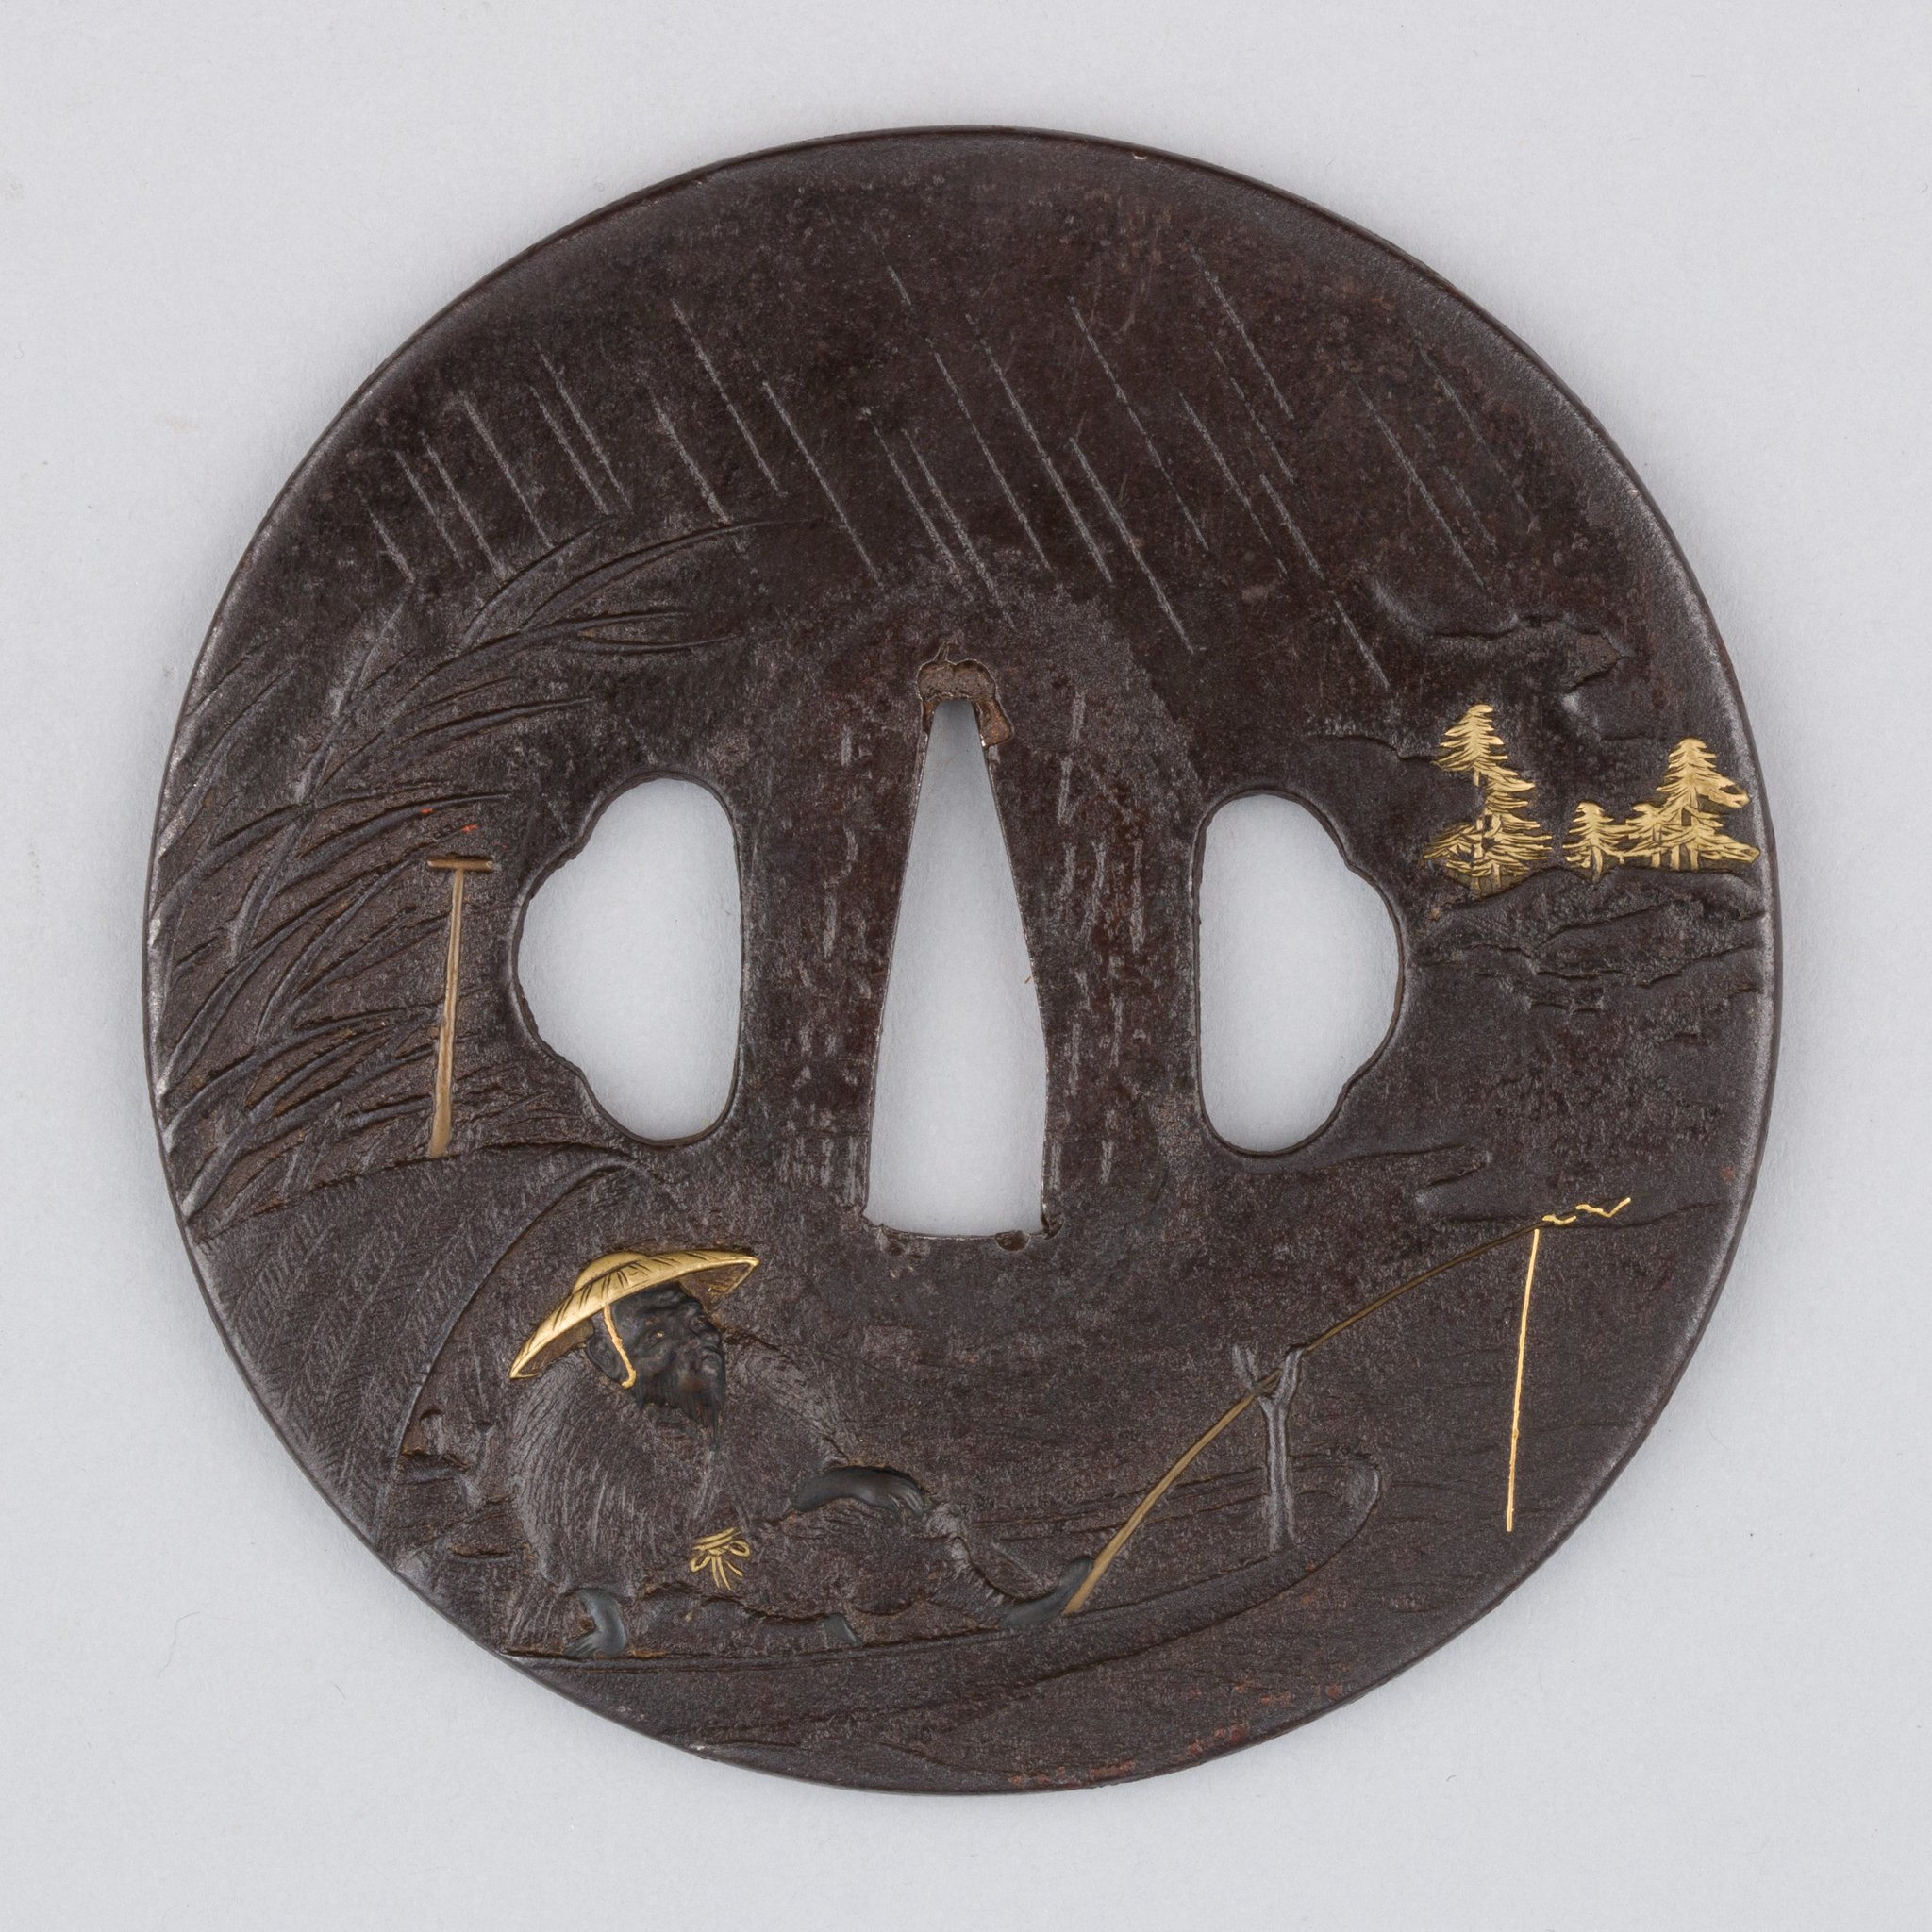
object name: sword guard tsuba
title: Sword Guard (Tsuba)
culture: japanese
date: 1601-1700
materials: copper, gold, iron, silver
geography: japan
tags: men,fishing